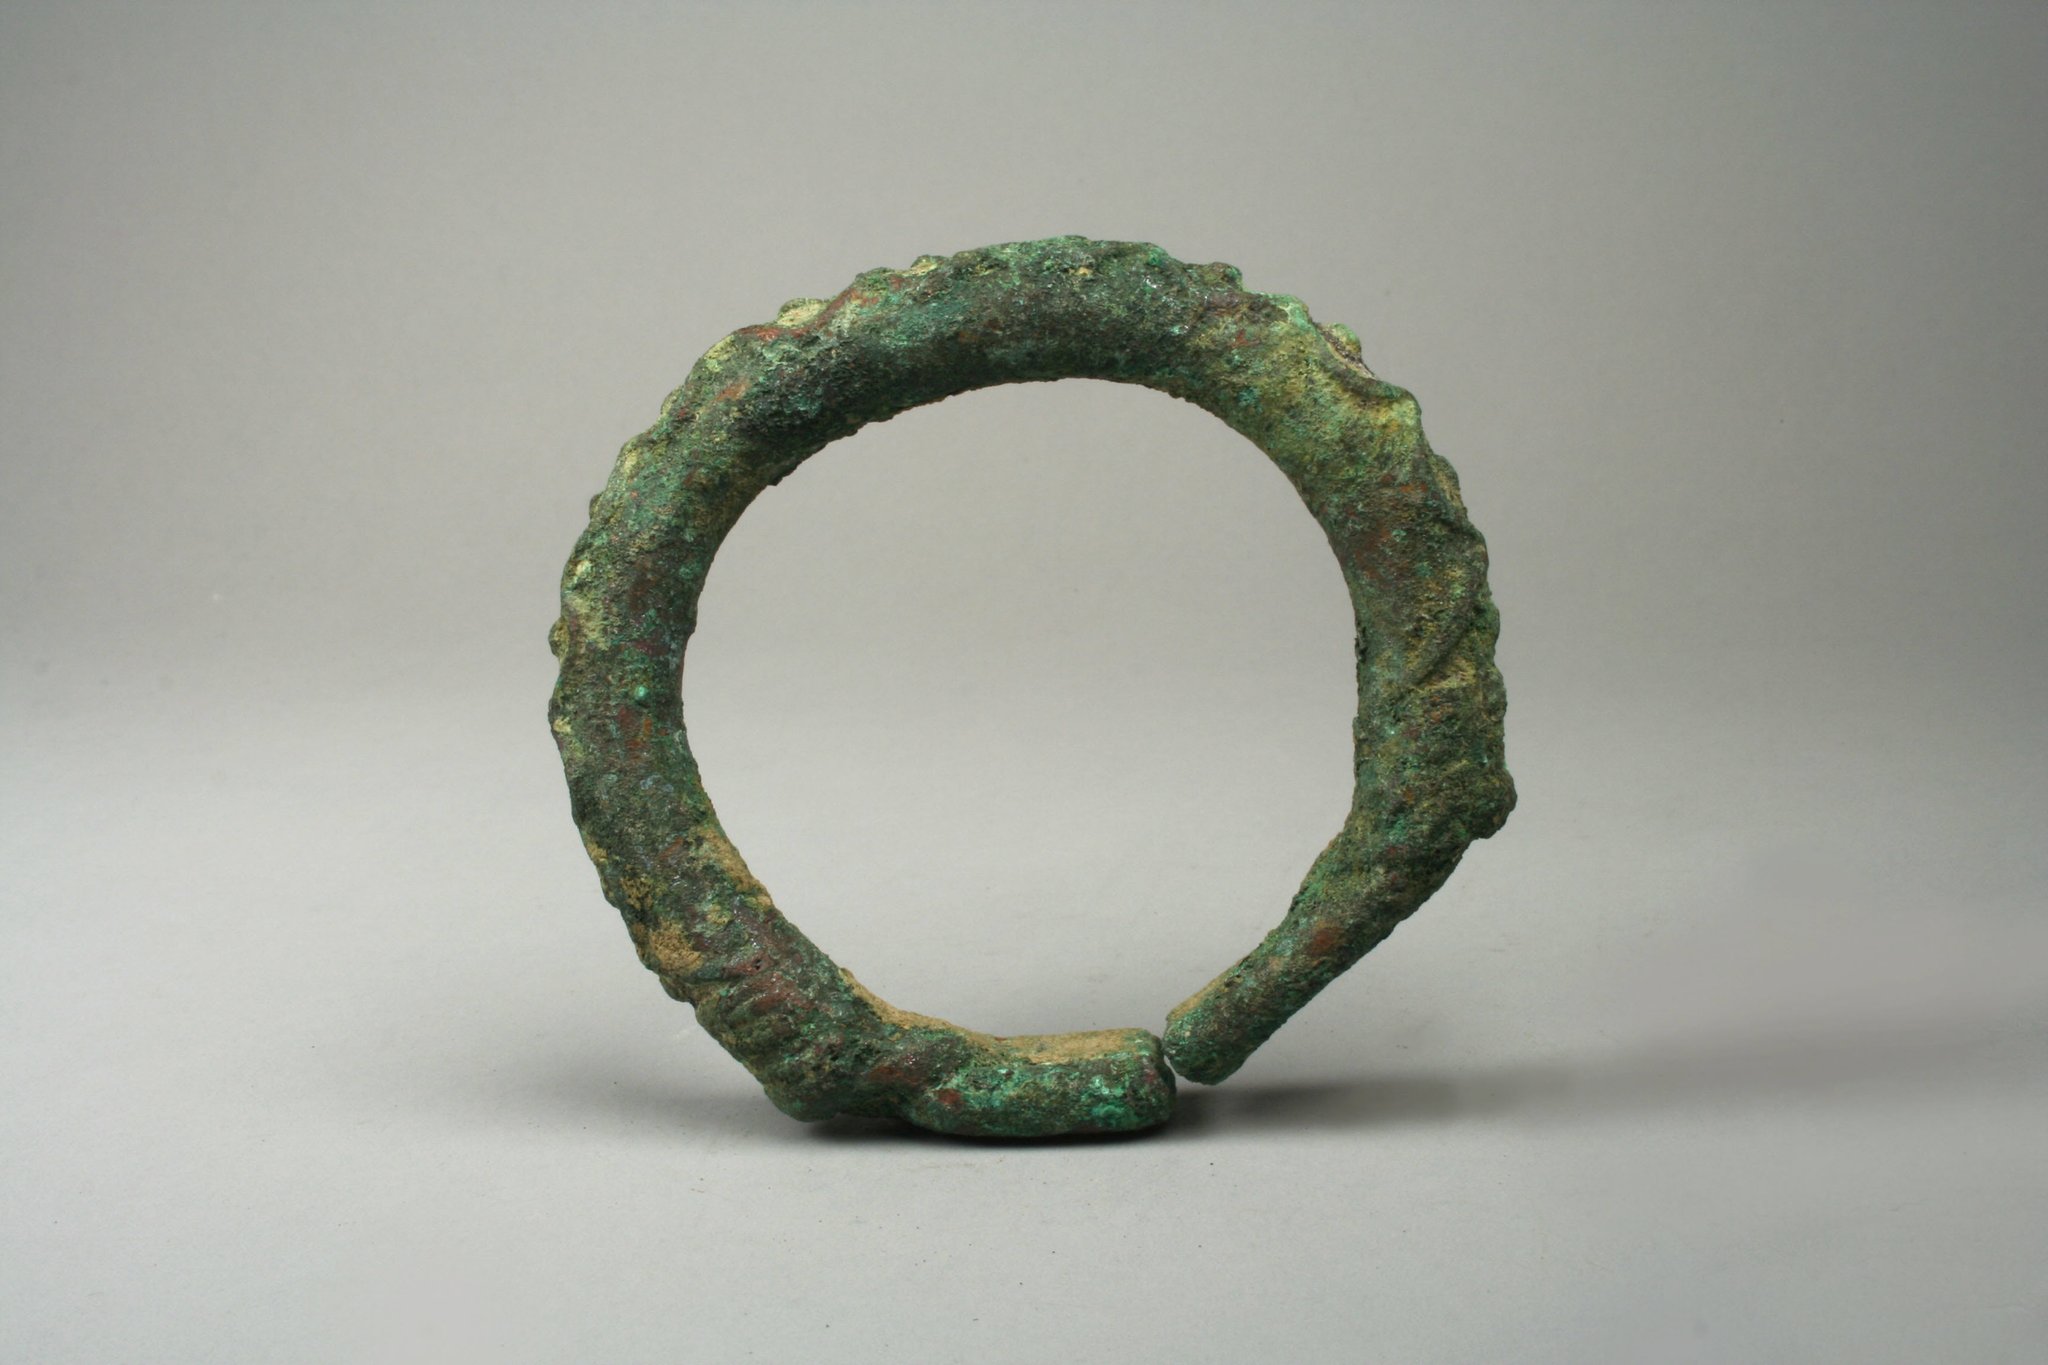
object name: bracelet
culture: middle niger civilization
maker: middle niger artist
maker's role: artist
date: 1001-1600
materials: copper alloy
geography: mali